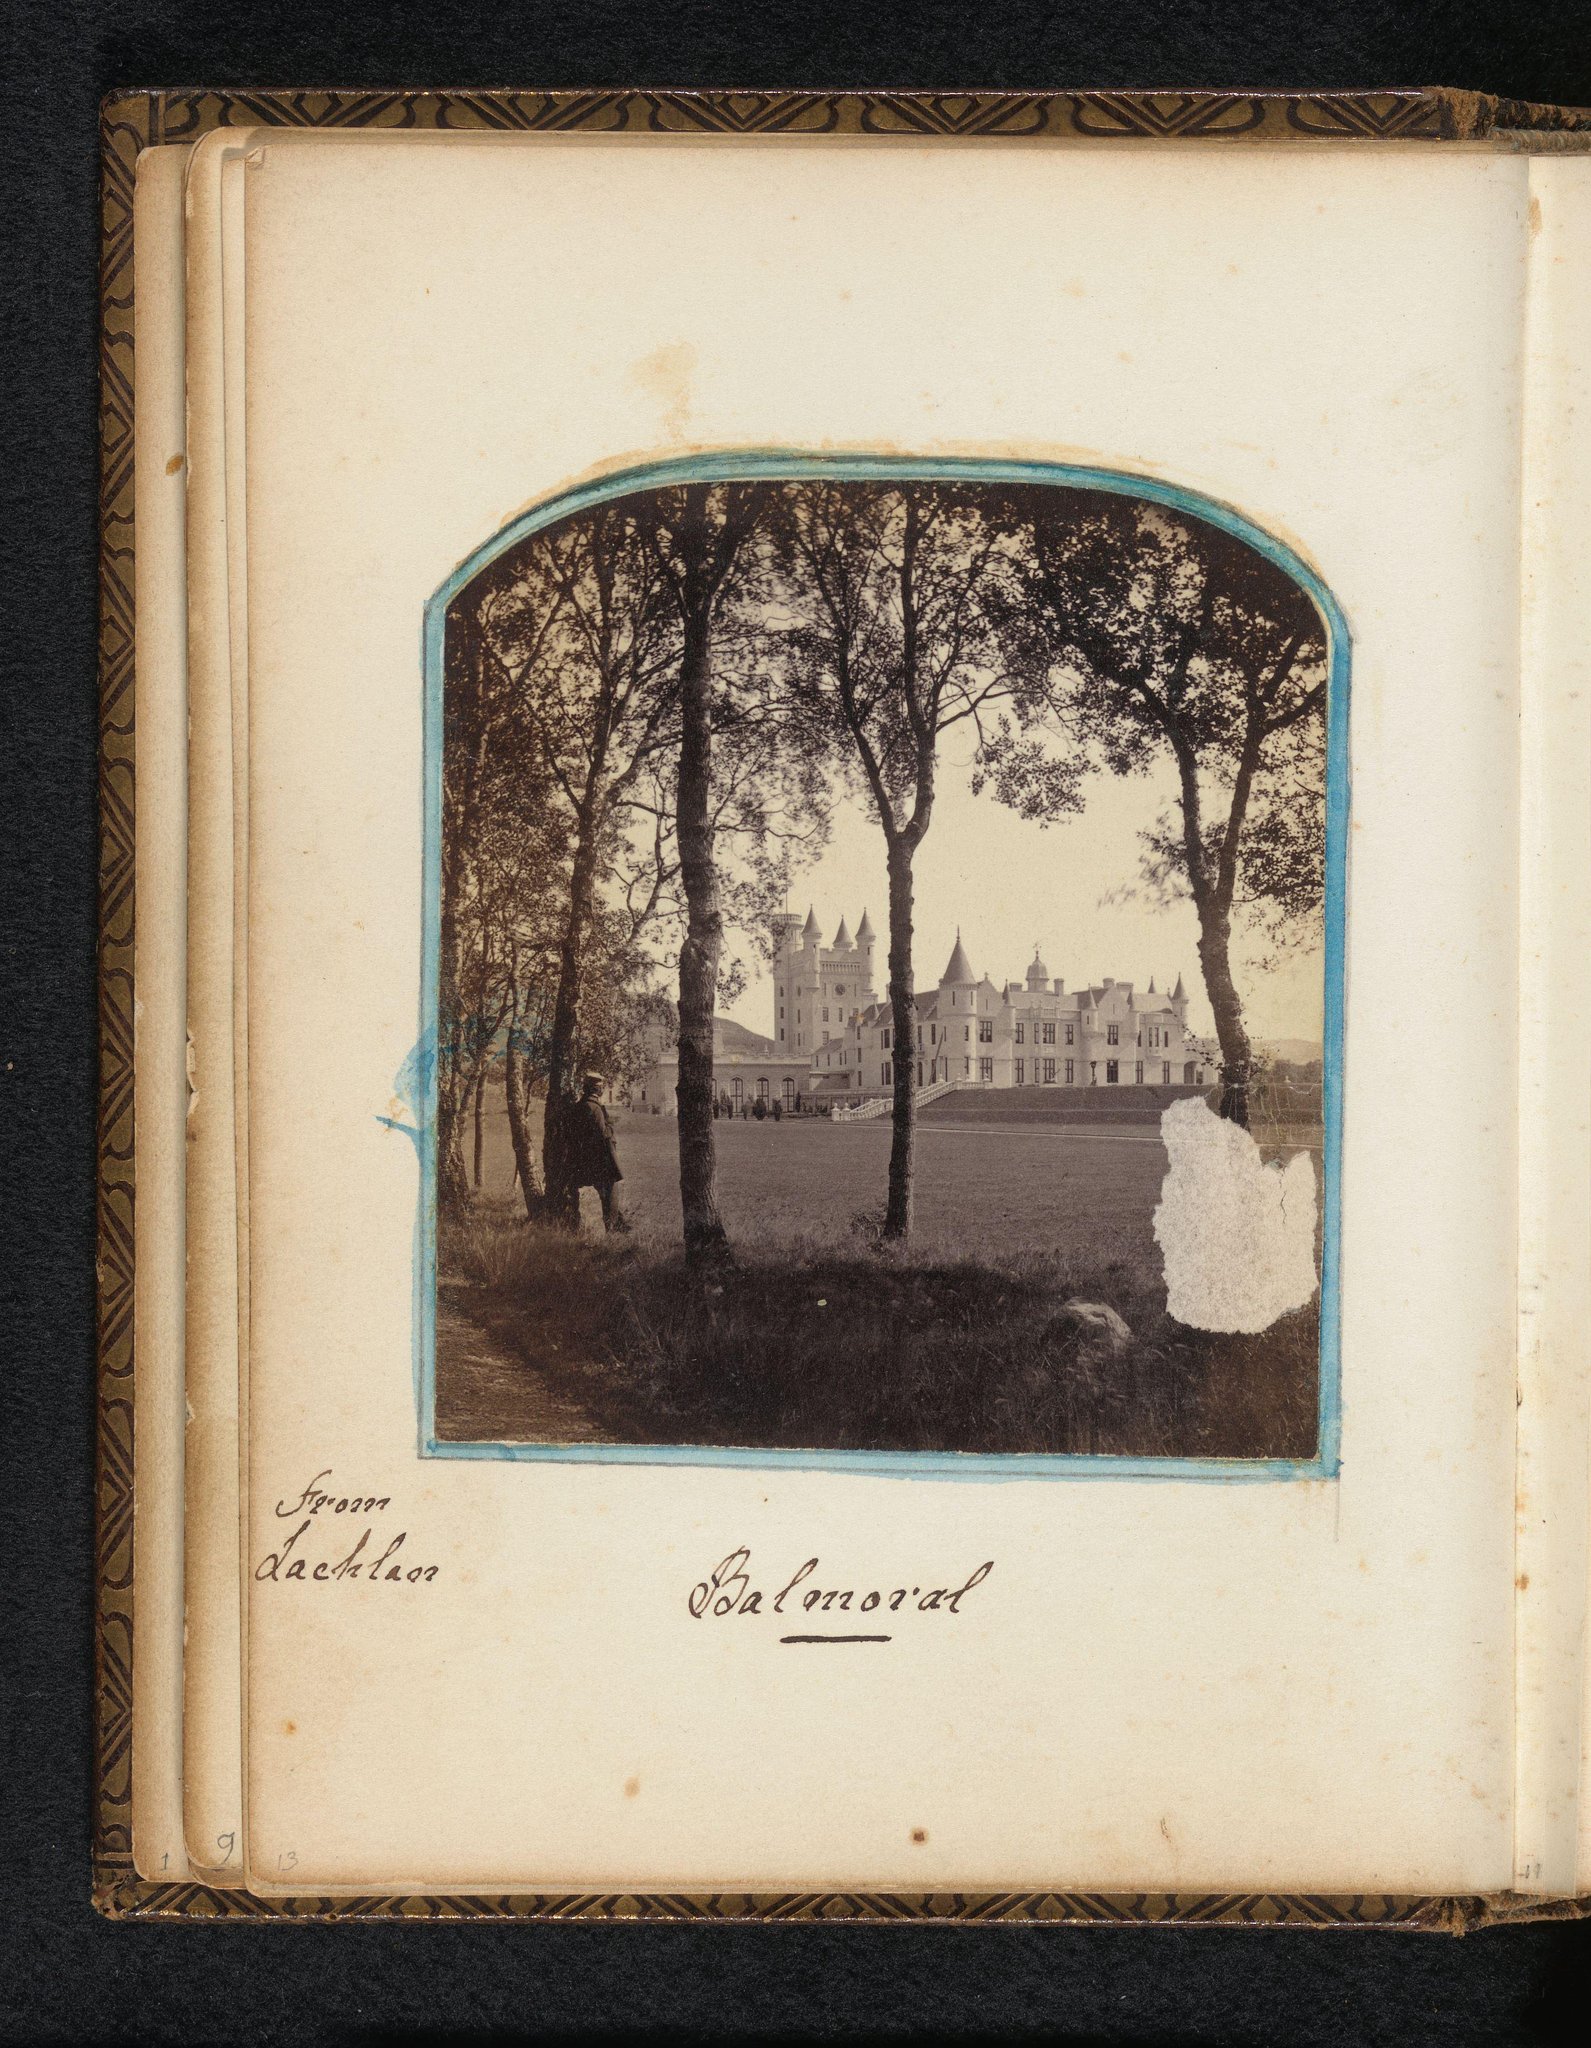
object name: album leaf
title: Balmoral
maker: Anonymous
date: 1865-1867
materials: cardboard, photographic support, watercolor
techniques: albumen print, aquarelle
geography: england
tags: castle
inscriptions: annotation: ‘from Lachlan / Balmoral’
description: Het kasteel Balmoral. Foto op albumblad in album met 68 foto's merendeels met geaquarelleerde randversieringen. Het zijn voornamelijk portretten op carte-de-visite formaat.